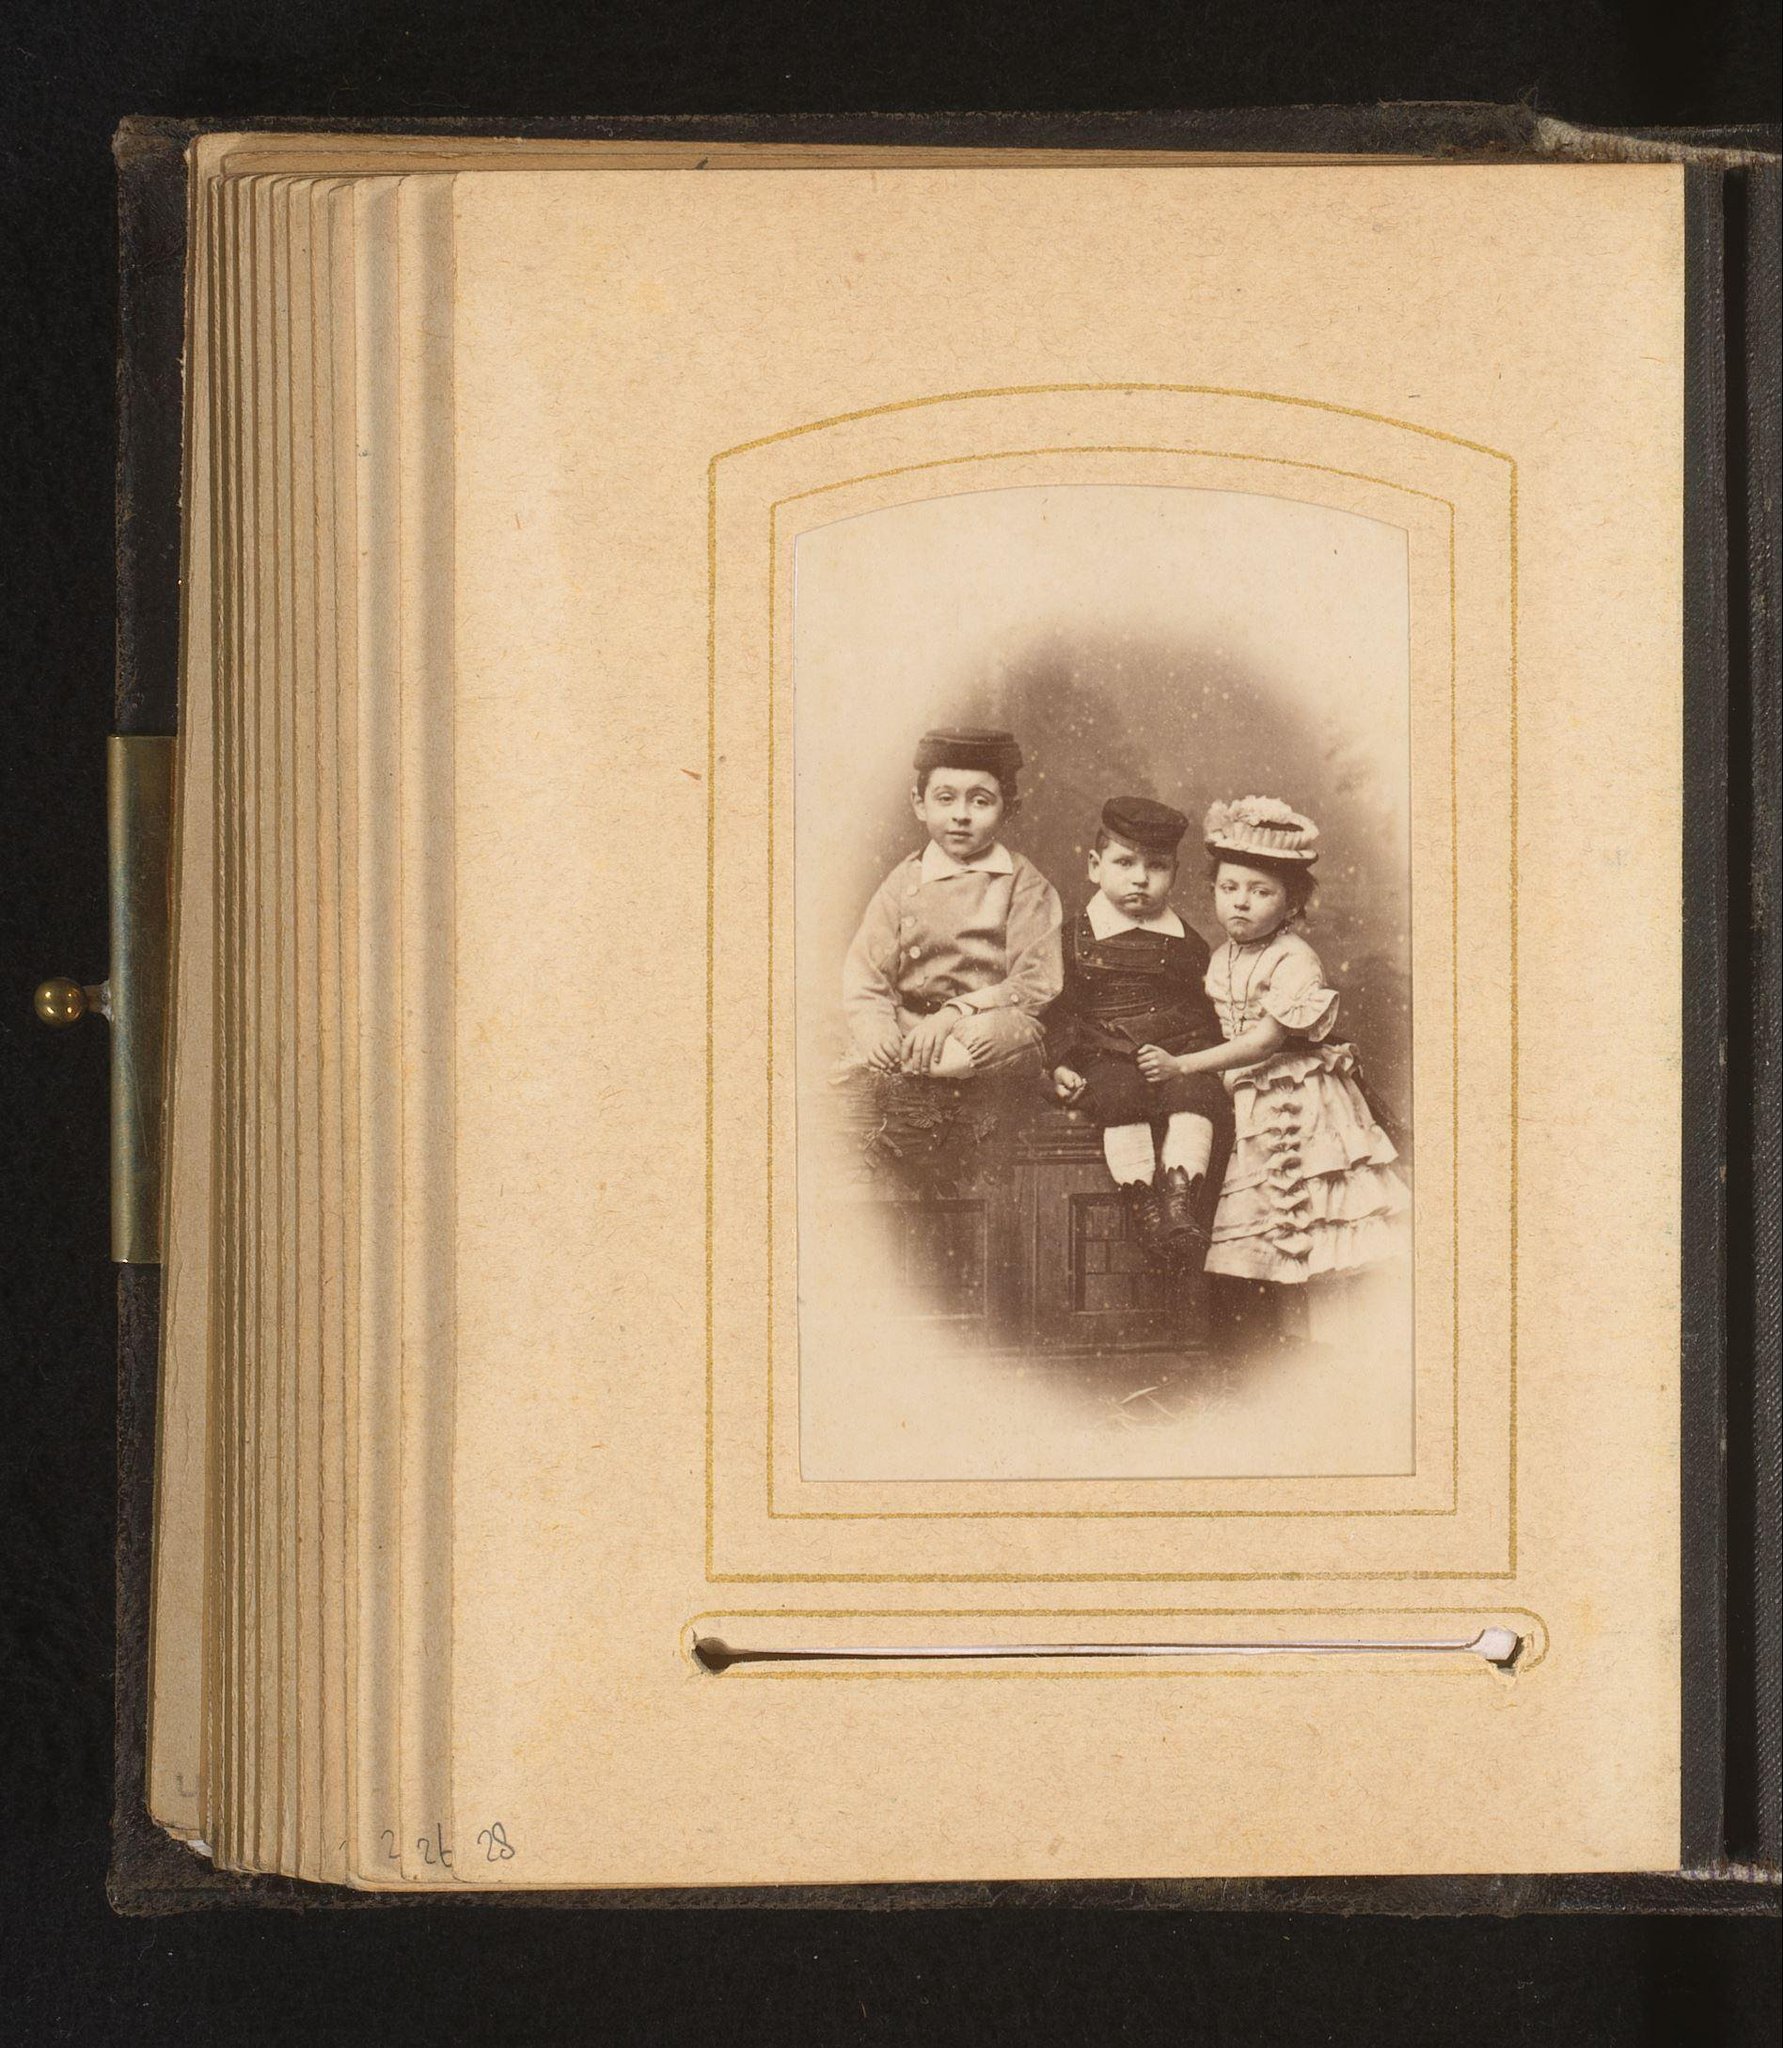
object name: photograph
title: Groepsportret met drie kinderen met hoeden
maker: johannes gerardus kramer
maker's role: fotograaf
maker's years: 1845-1903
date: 1868-1903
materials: cardboard, photographic support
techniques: albumen print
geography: groningen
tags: child, anonymous historical persons portrayed in a group, in a group-portrait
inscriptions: inscription: ‘Photographisches Atelier/ J.G. Kramer/ Groningen’